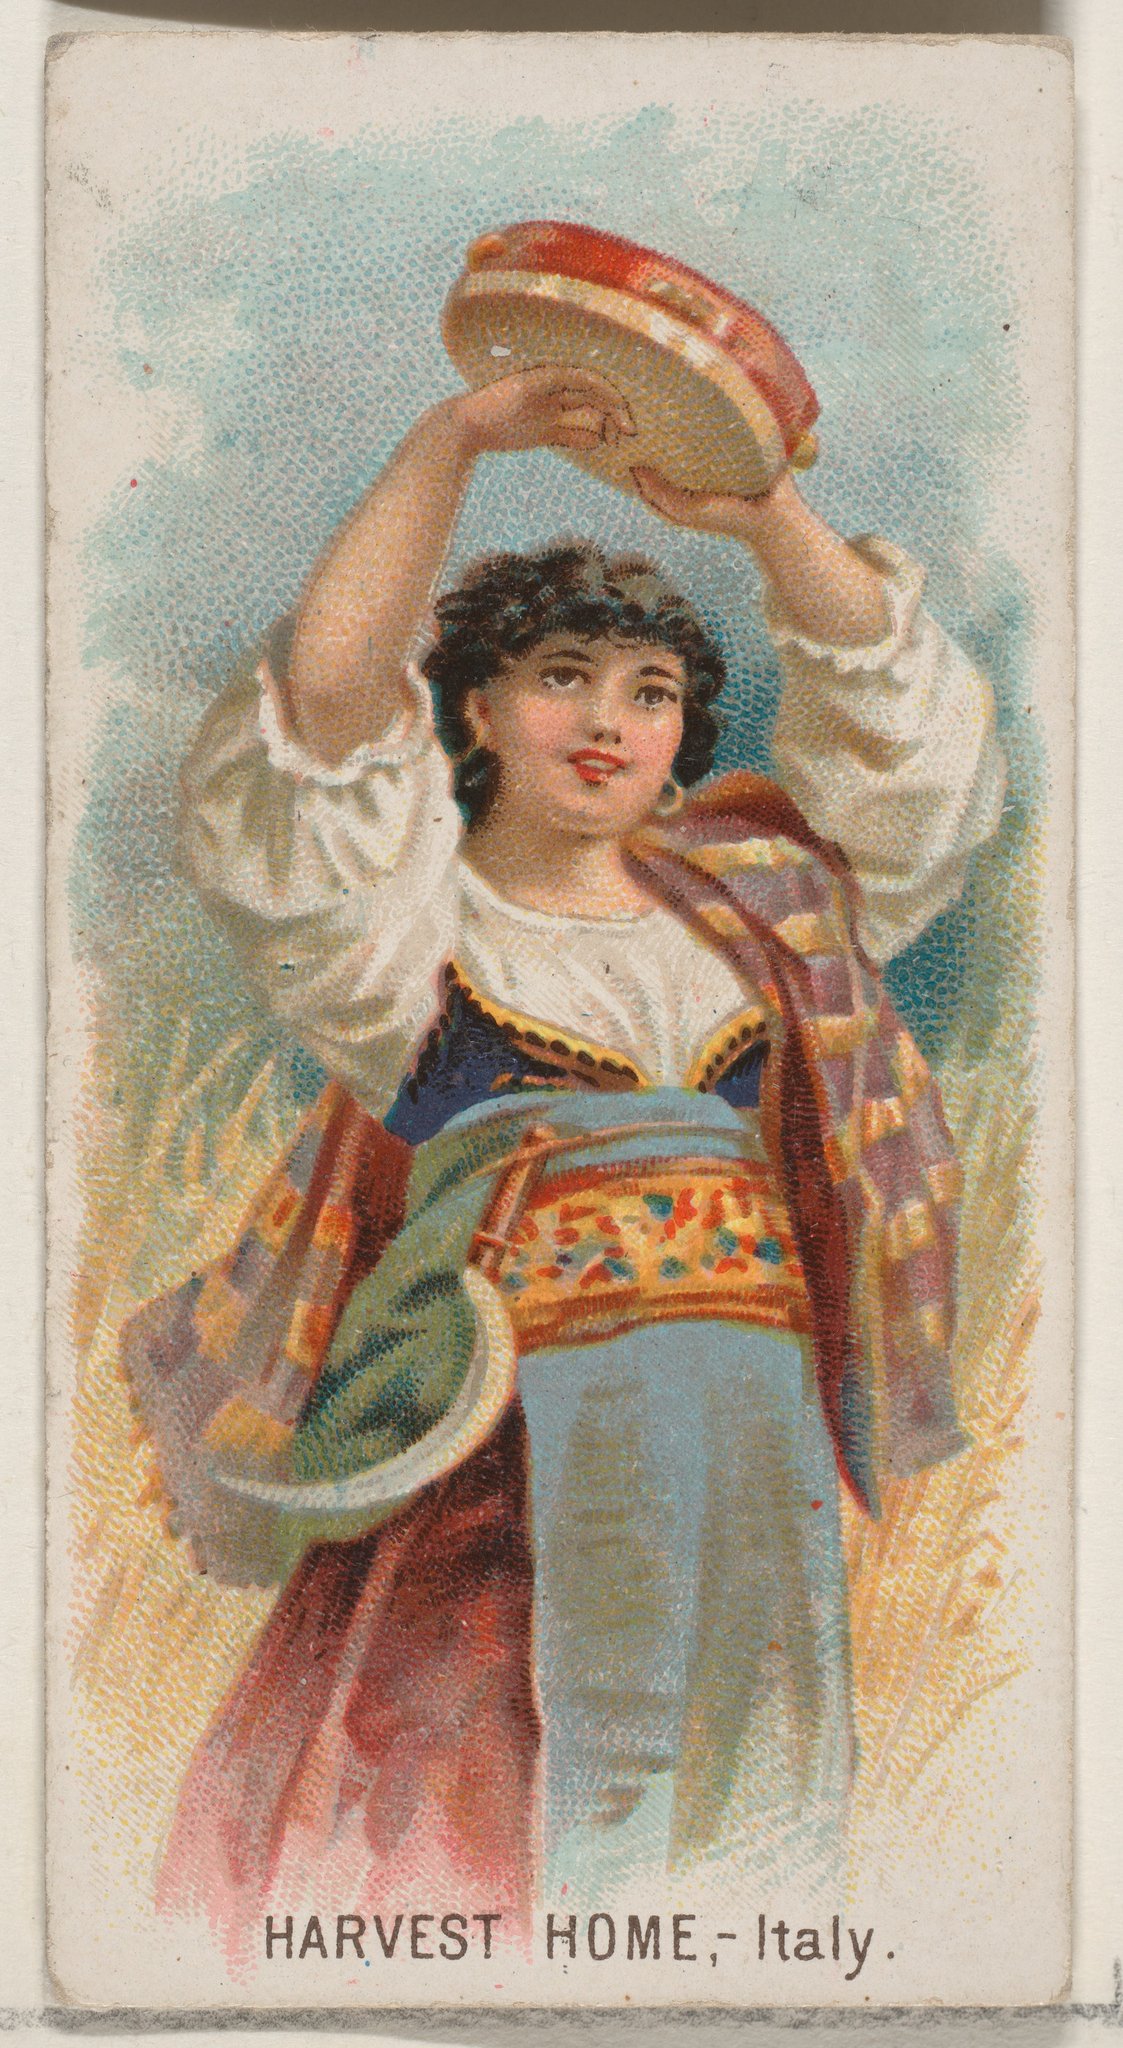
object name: print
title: Harvest Home, Italy, from the Holidays series (N80) for Duke brand cigarettes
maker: w. duke, sons & co.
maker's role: publisher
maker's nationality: american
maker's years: 1870-1920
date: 1890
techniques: color lithograph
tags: women